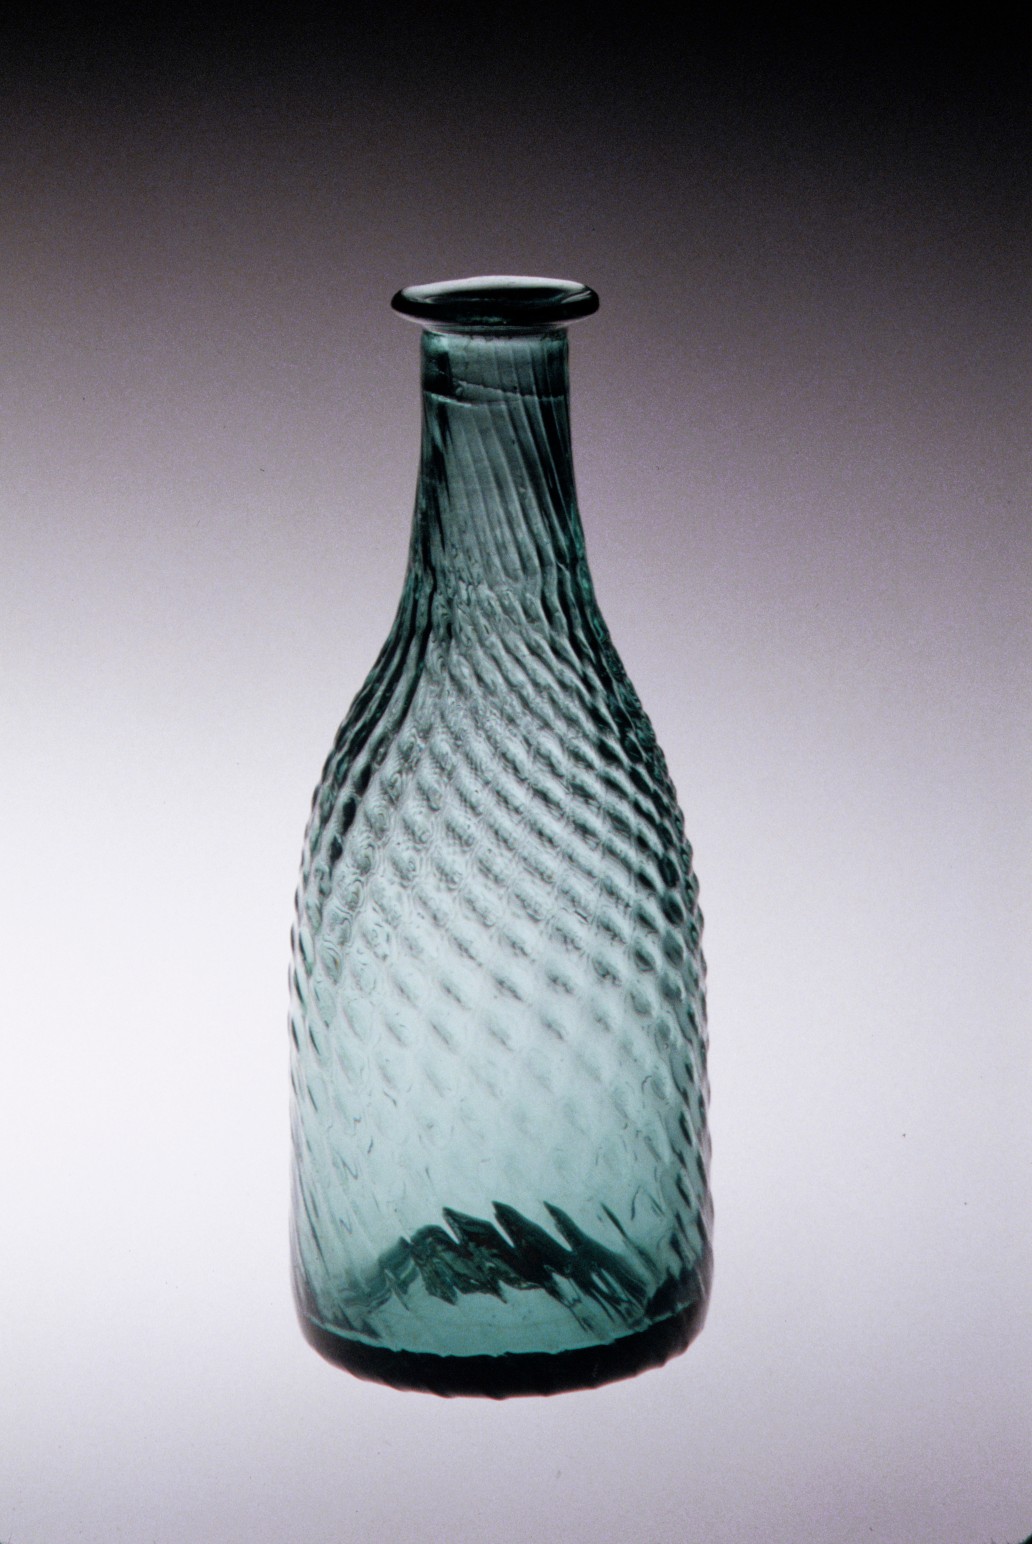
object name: bottle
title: Castor Bottle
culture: american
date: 1800-1860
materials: glass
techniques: glassblowing, molding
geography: united states